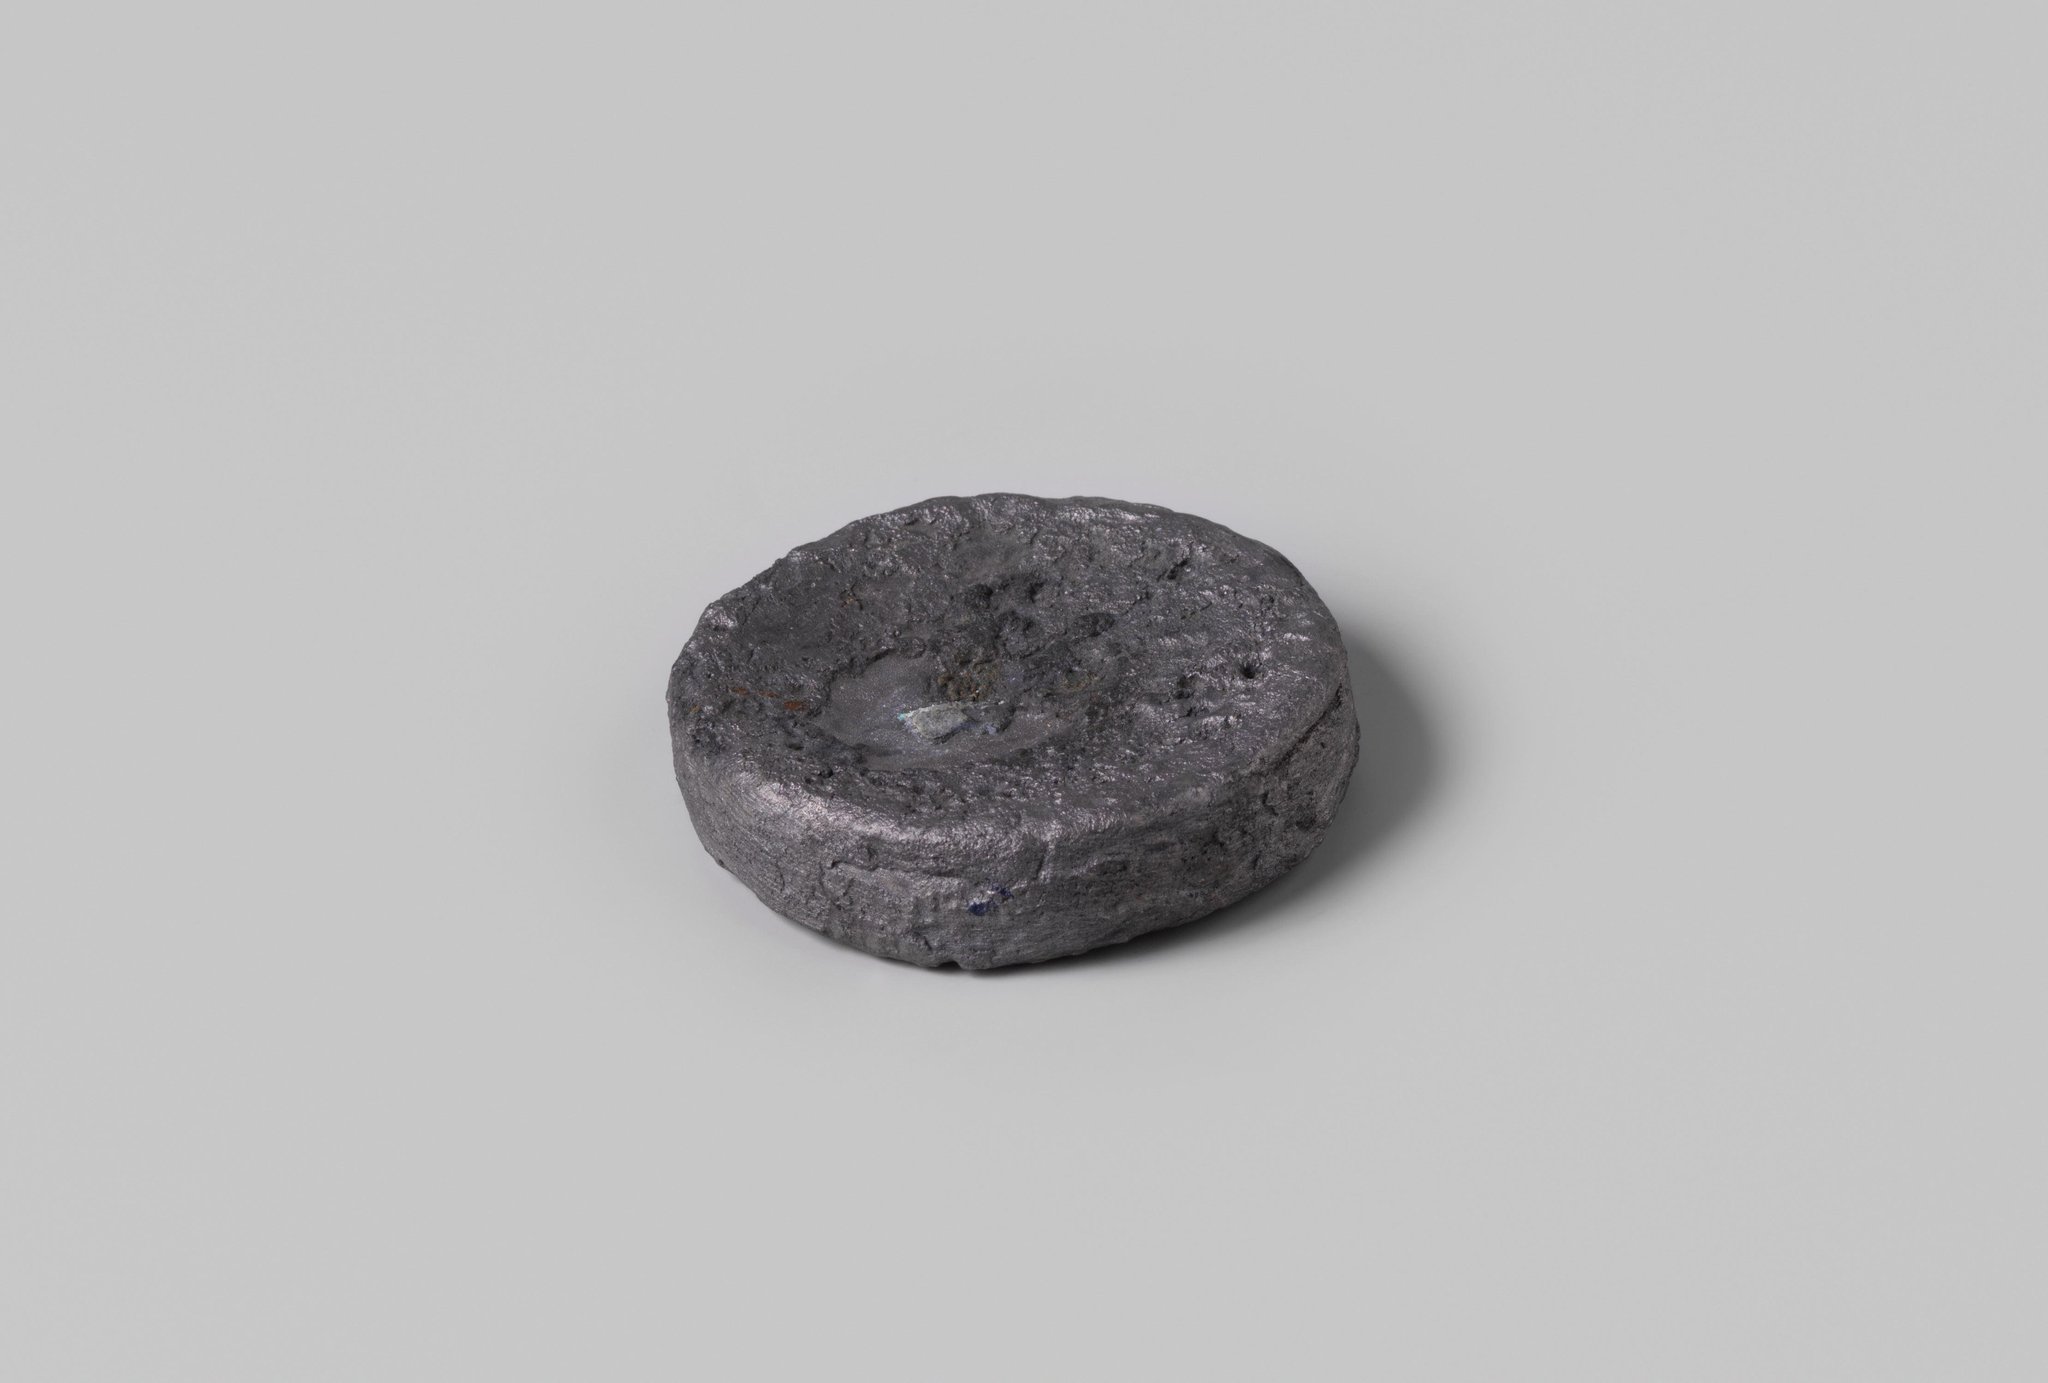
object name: weight scale component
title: Gewicht uit het wrak van de Oost-Indiëvaarder Hollandia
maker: Anonymous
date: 1700-1743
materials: lead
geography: netherlands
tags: verenigde oostindische compagnie, hollandia (schip), annet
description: Disc-shaped weight, id. NG 1980-27H2773, eroded.